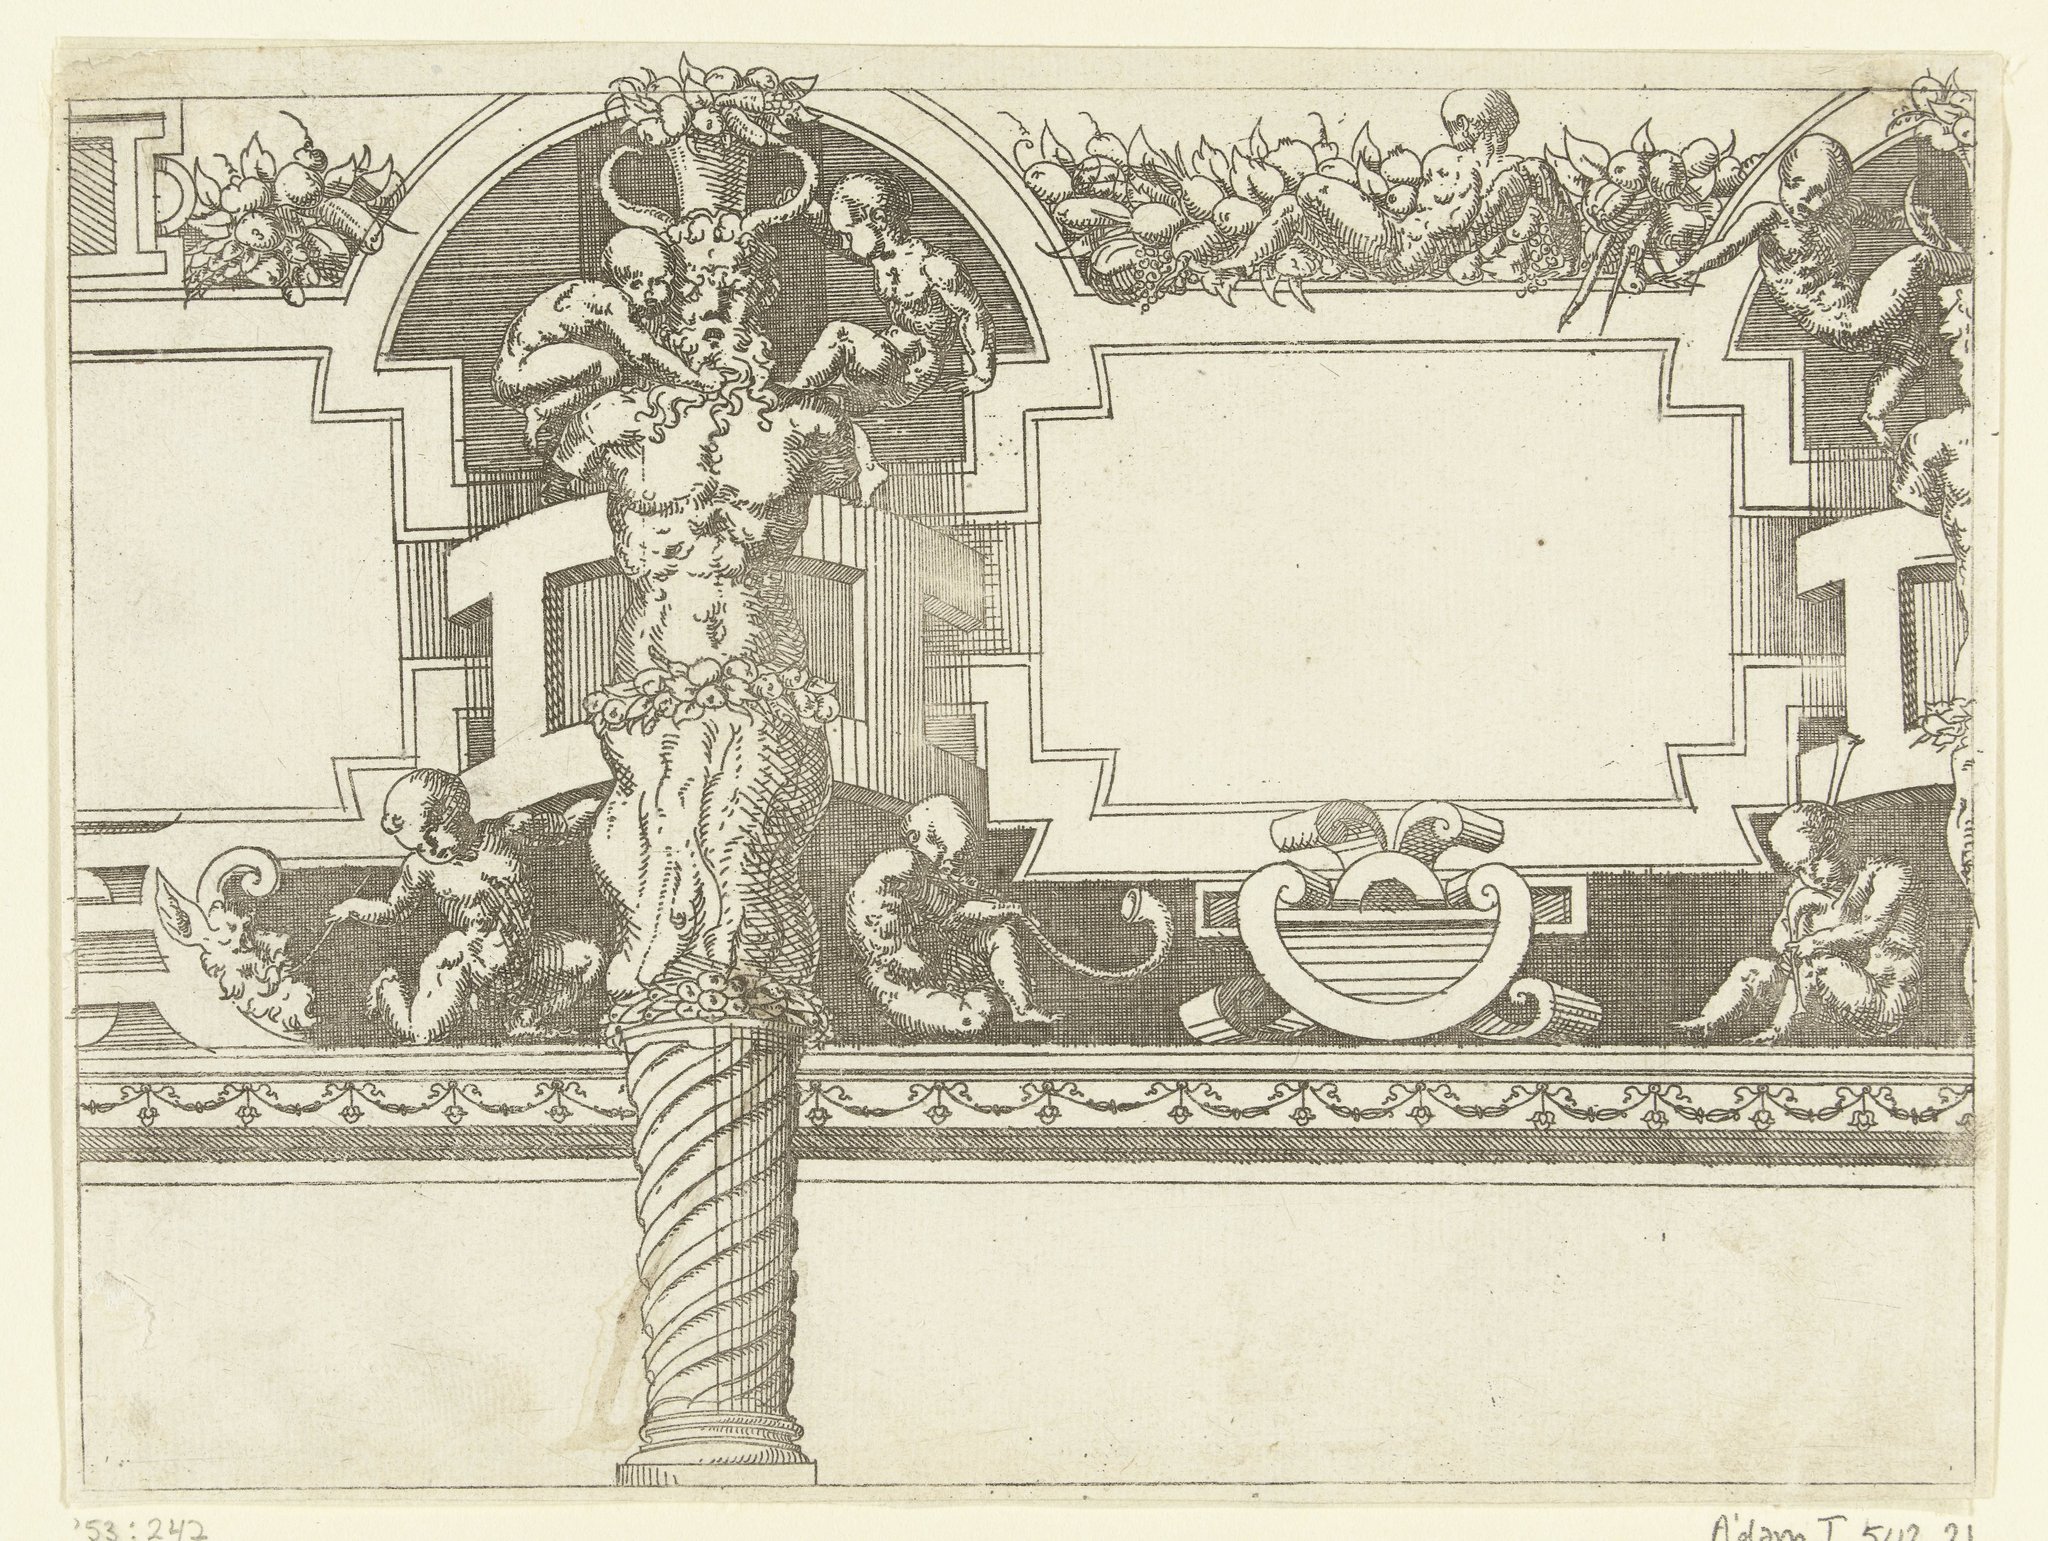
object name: print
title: Herme tussen twee rechthoekige cartouches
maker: Anonymous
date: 1520-1584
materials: paper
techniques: etching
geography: france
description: De herme heeft een mand met vruchten op zijn hoofd en twee kinderen op zijn schouders. Uit serie van 32 bladen. De cartouches zijn deels ontleend aan de prenten van Antonio Fantuzzi naar de decoratie van de Galerie van François 1er door Giovanni Battista Rosso. De serie staat ook bekend onder de titel Petits cartouches de Fontainebleau.